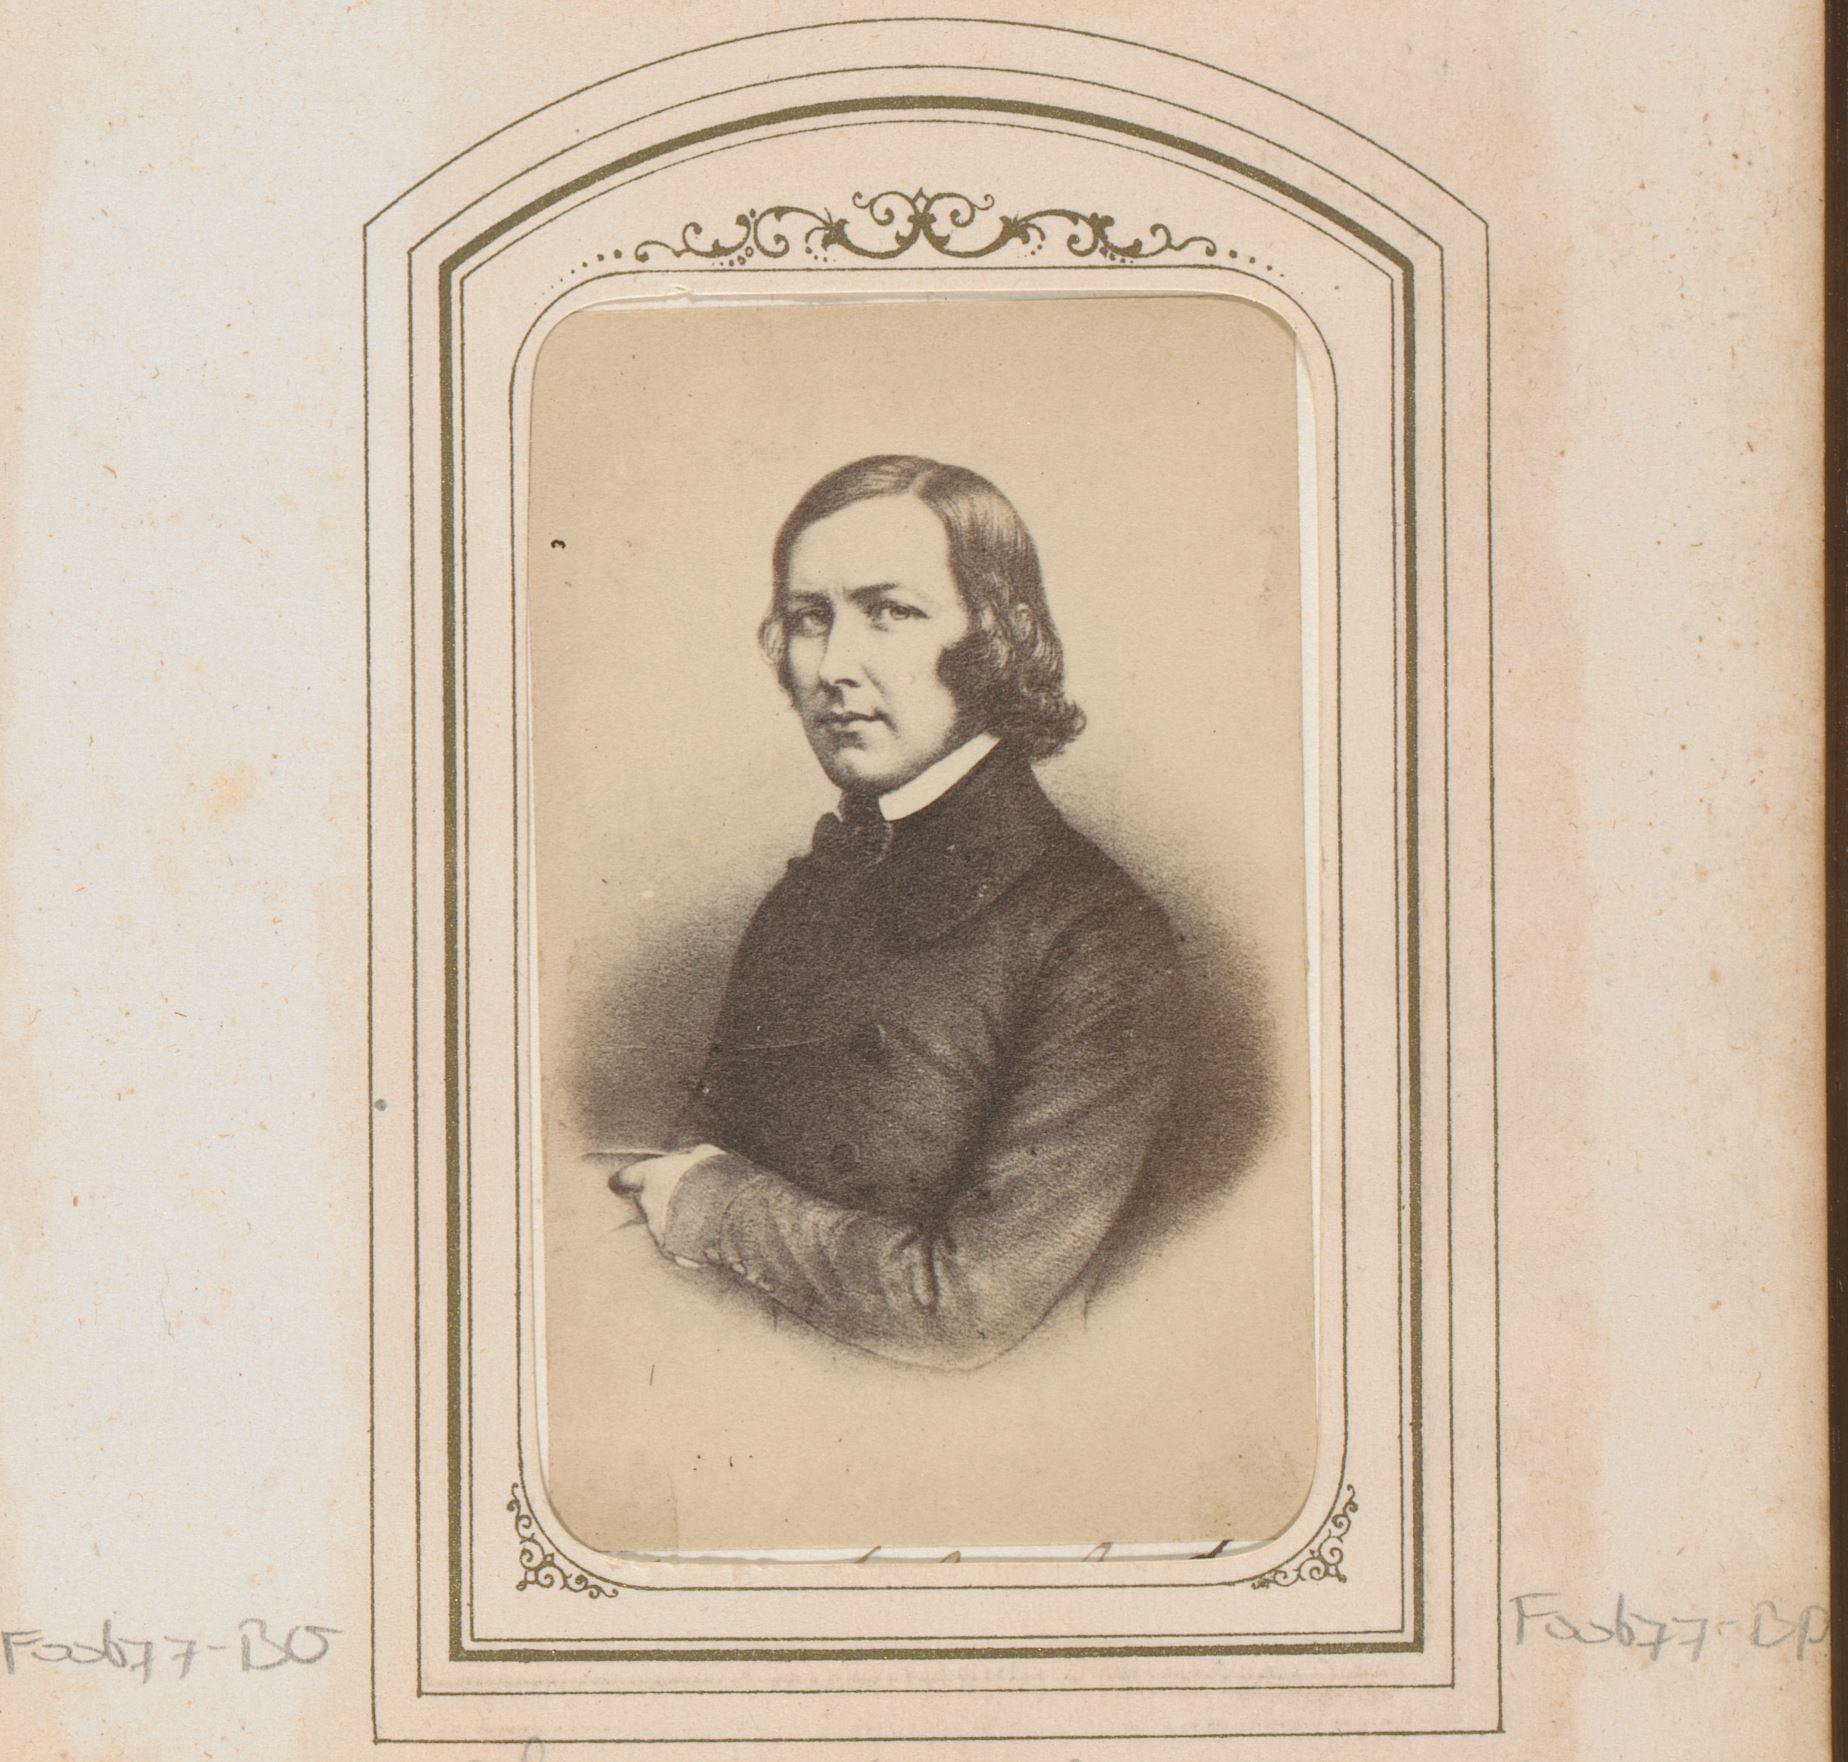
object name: carte de visite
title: Fotoreproductie van een getekend portret van Charles de Montalembert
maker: Anonymous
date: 1850-1900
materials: cardboard, photographic support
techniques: albumen print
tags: london, paris, earl, politician, historical persons, politician, e.g. party leader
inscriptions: annotation: ‘Charles de Montalembert 1810/70/ Fr staatsman’, number: ‘248’, name: ‘Montalembert’